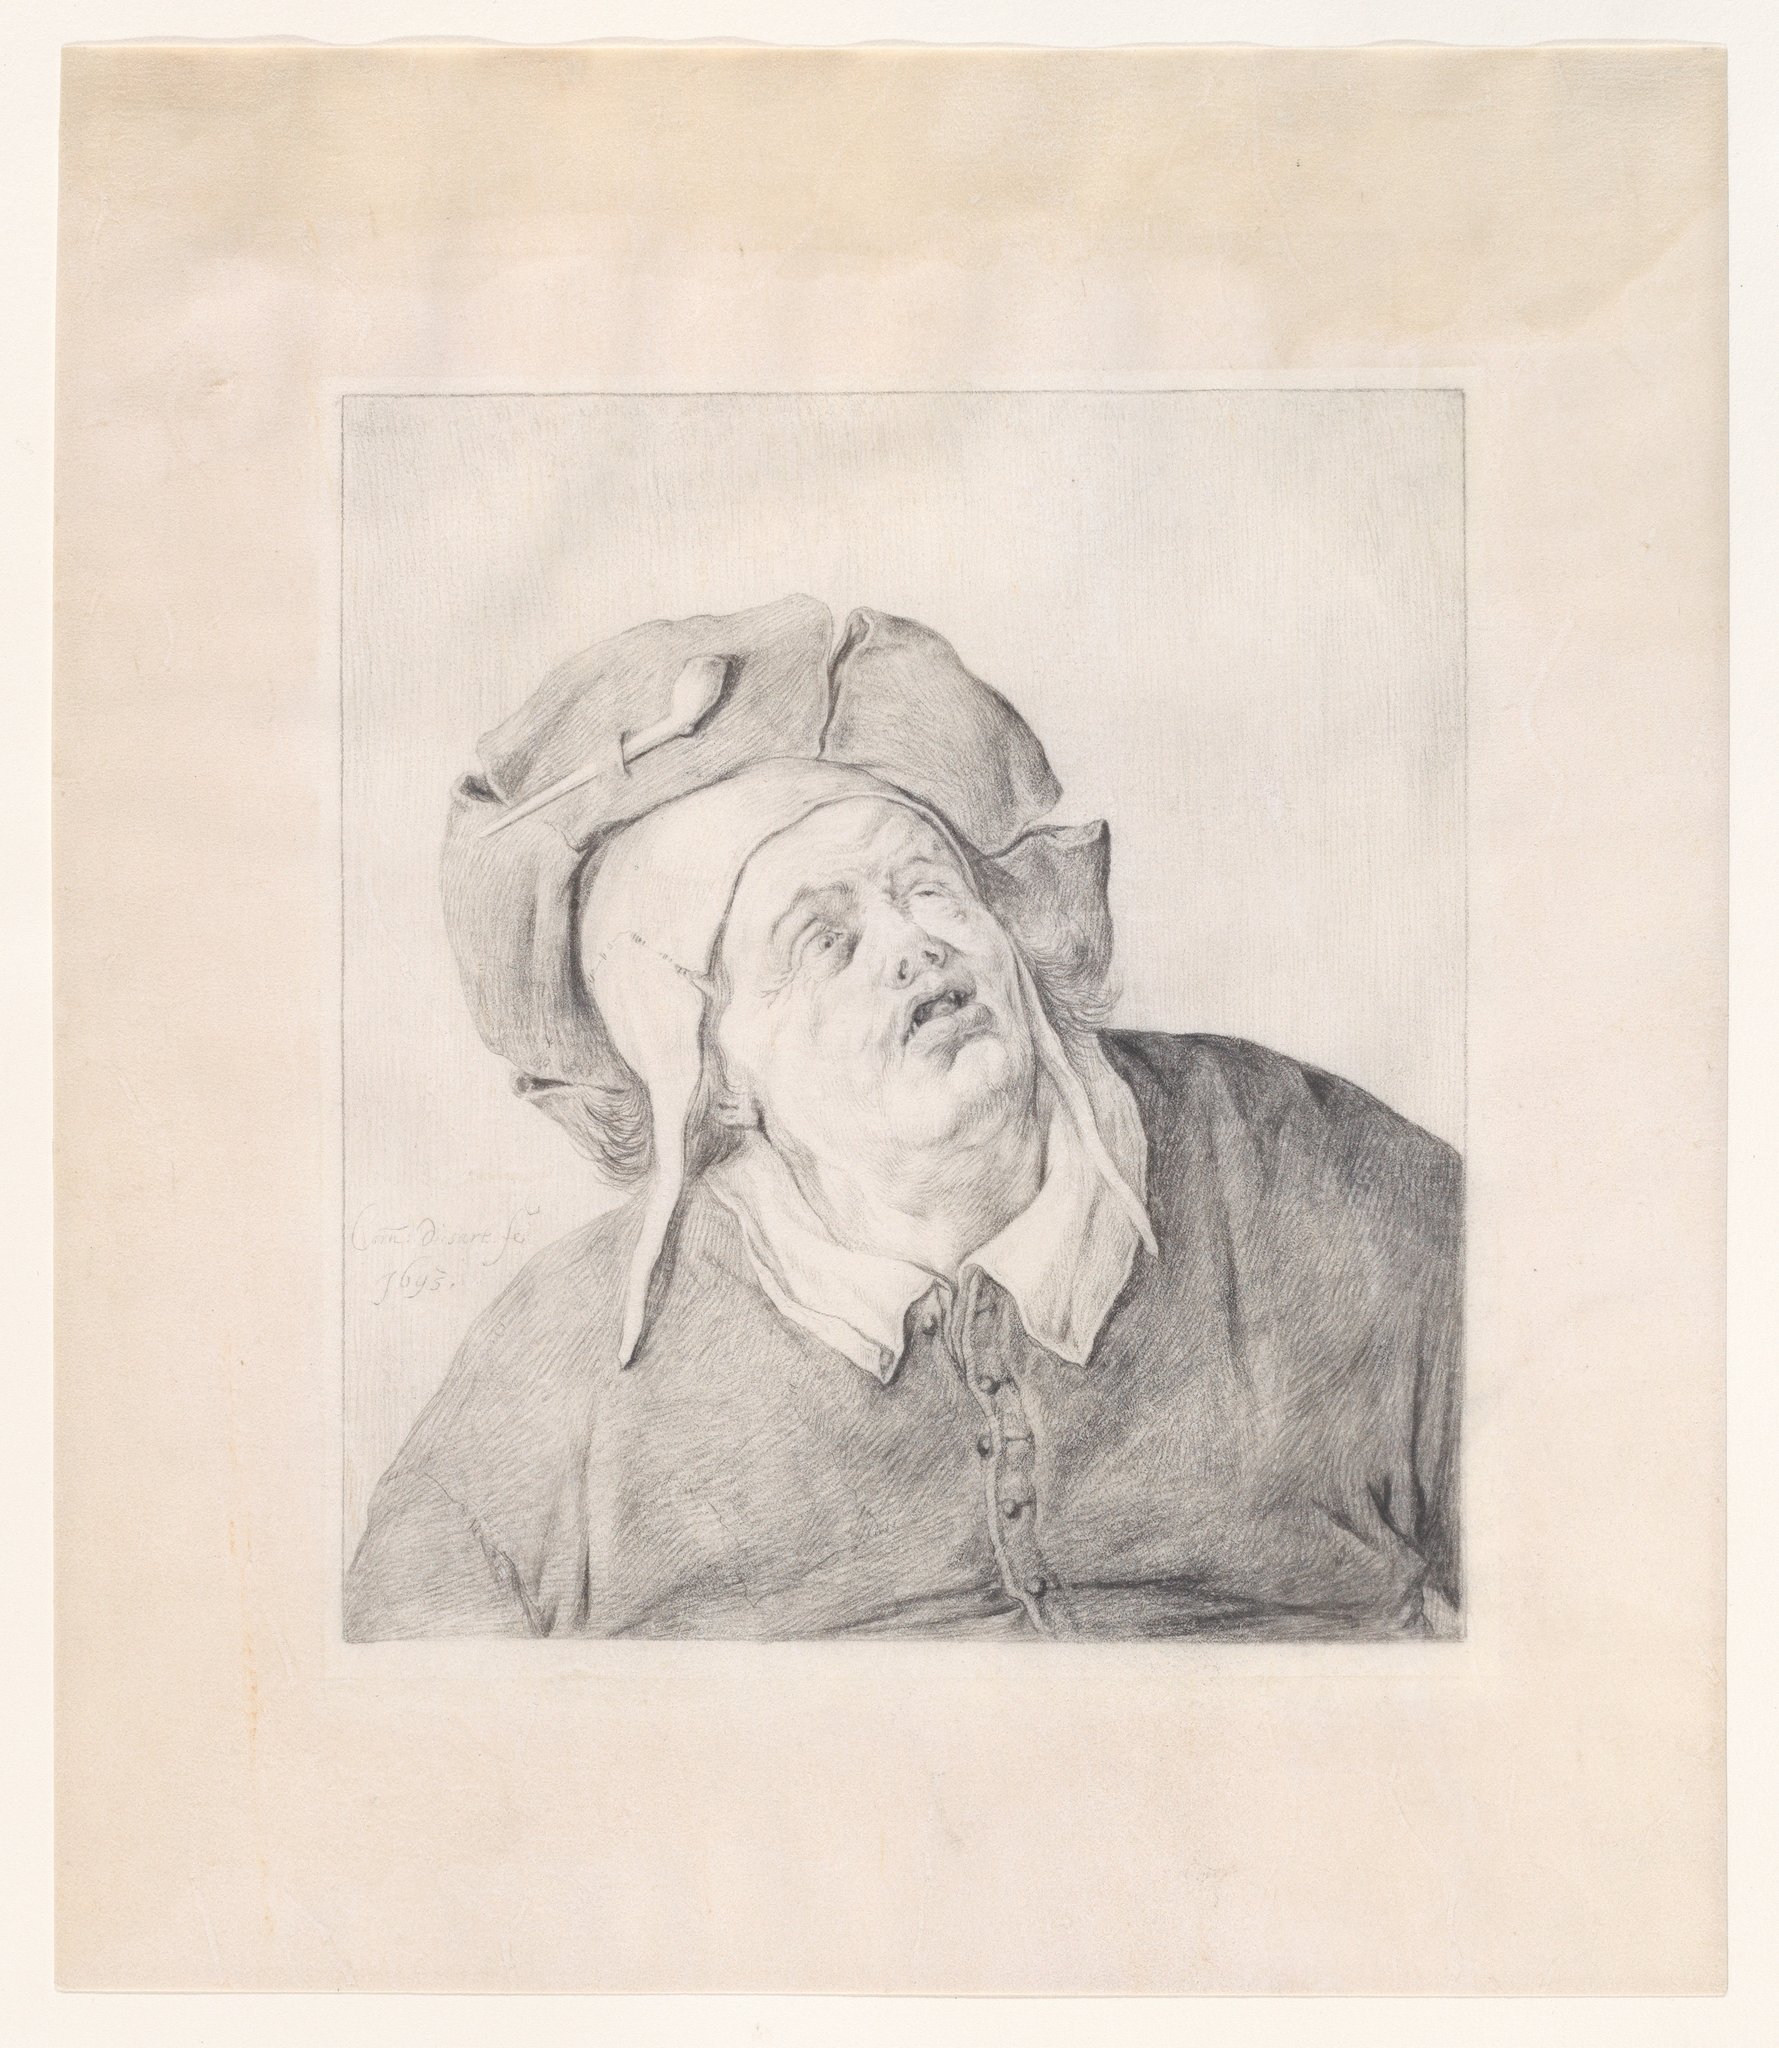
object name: drawing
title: A man in a hat looking up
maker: cornelis dusart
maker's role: artist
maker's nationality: dutch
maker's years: 1660-1704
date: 1693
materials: chalk, parchment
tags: men